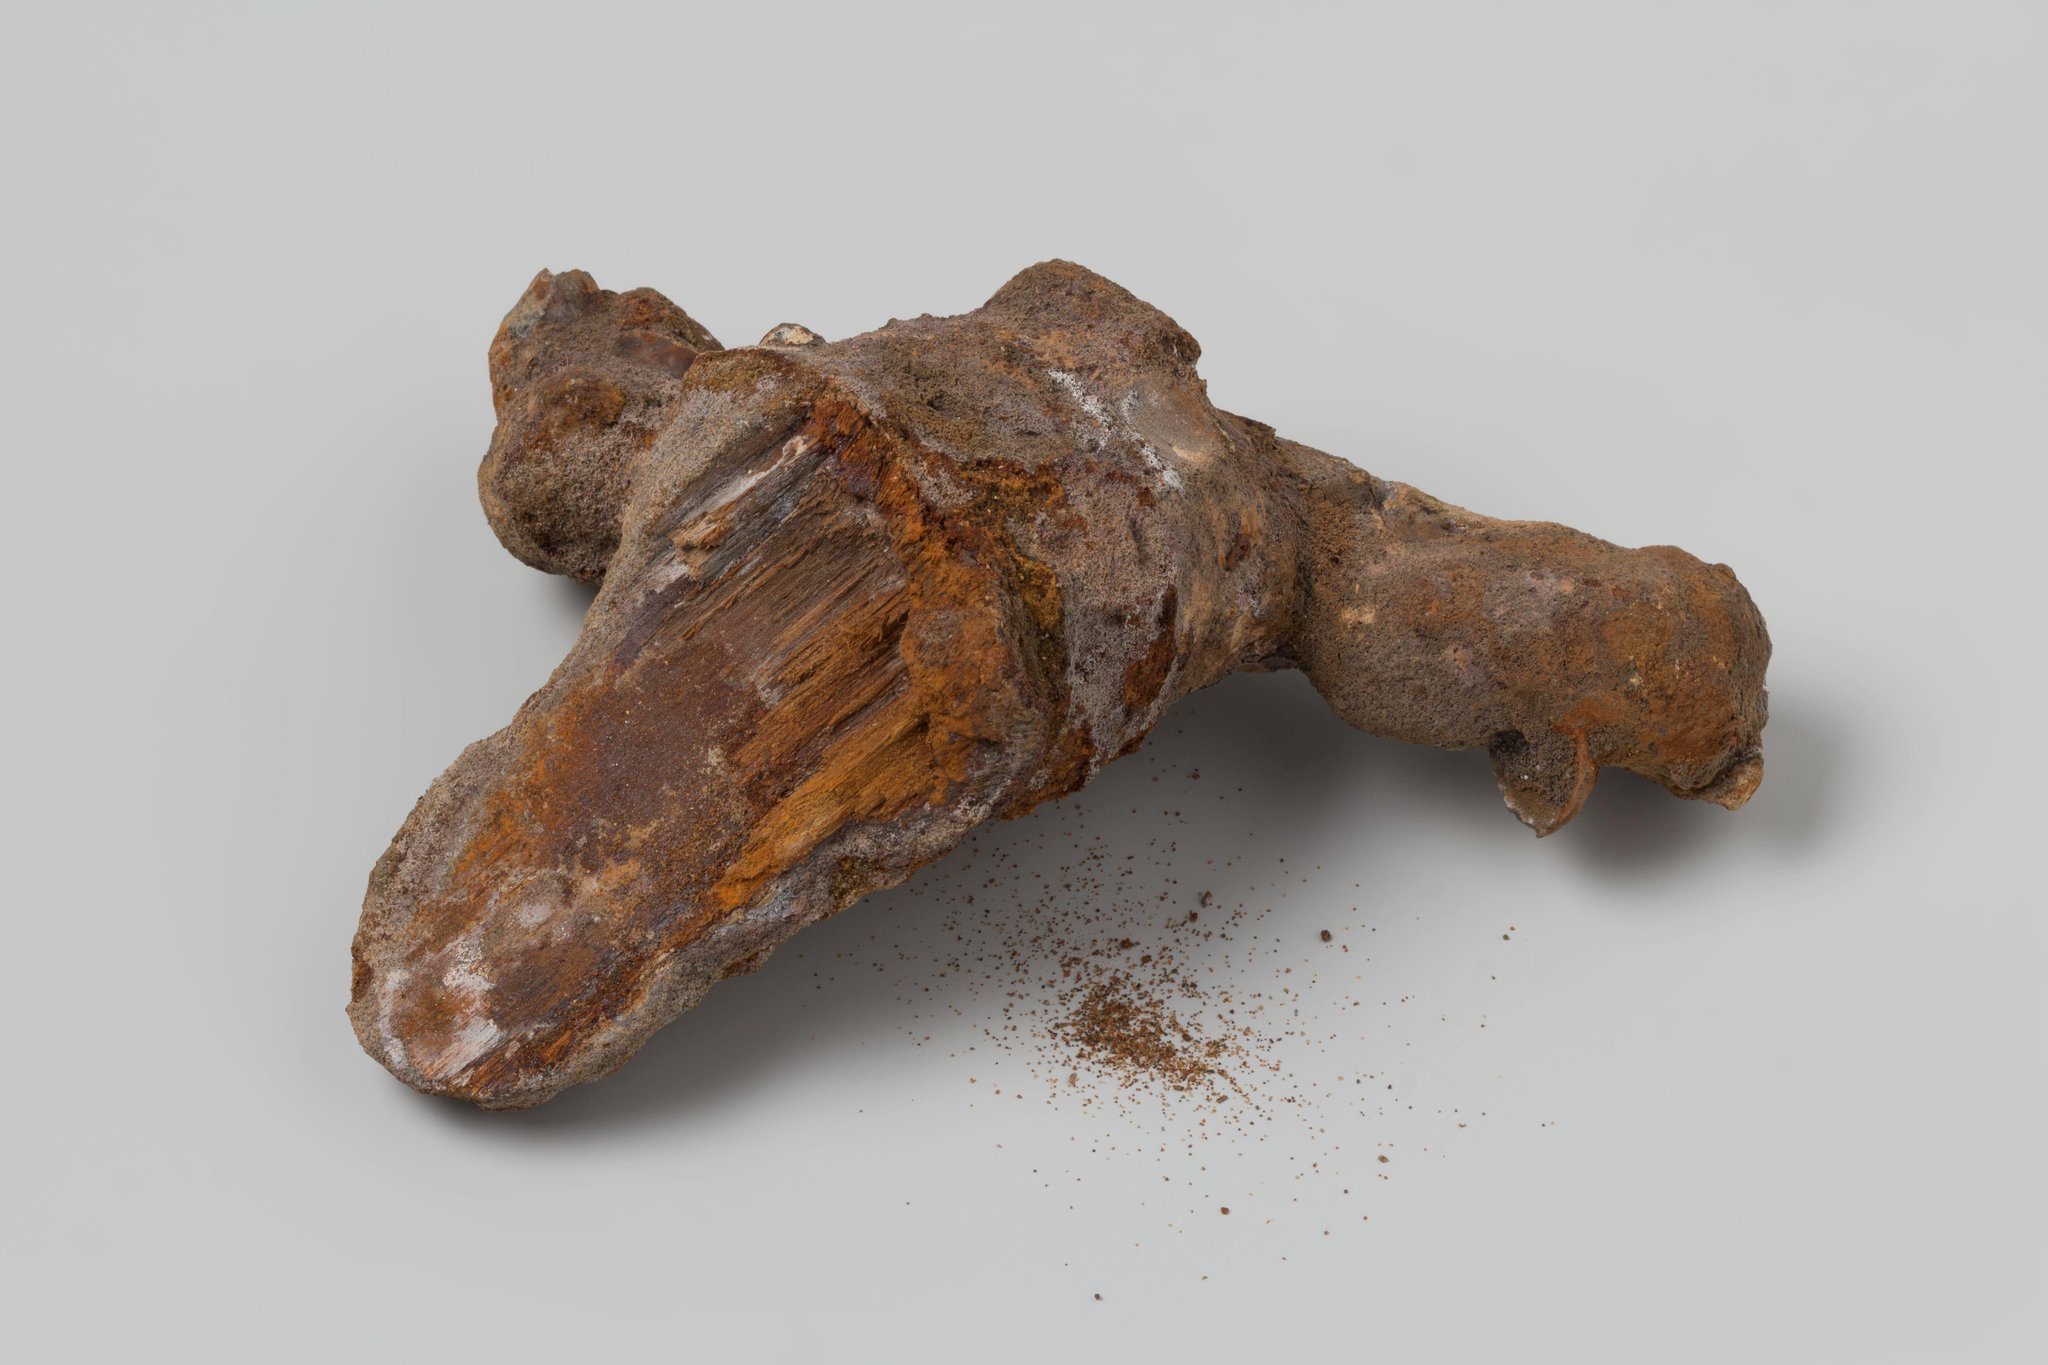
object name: concretionary stone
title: Fragment hout met gecorrodeerd ijzerbeslag uit het wrak van de Oost-Indiëvaarder 't Vliegend Hart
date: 1700-1735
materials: stone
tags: 't vliegend hart (schip), verenigde oostindische compagnie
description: De concretie bevat de afdruk van hout. Concretion.